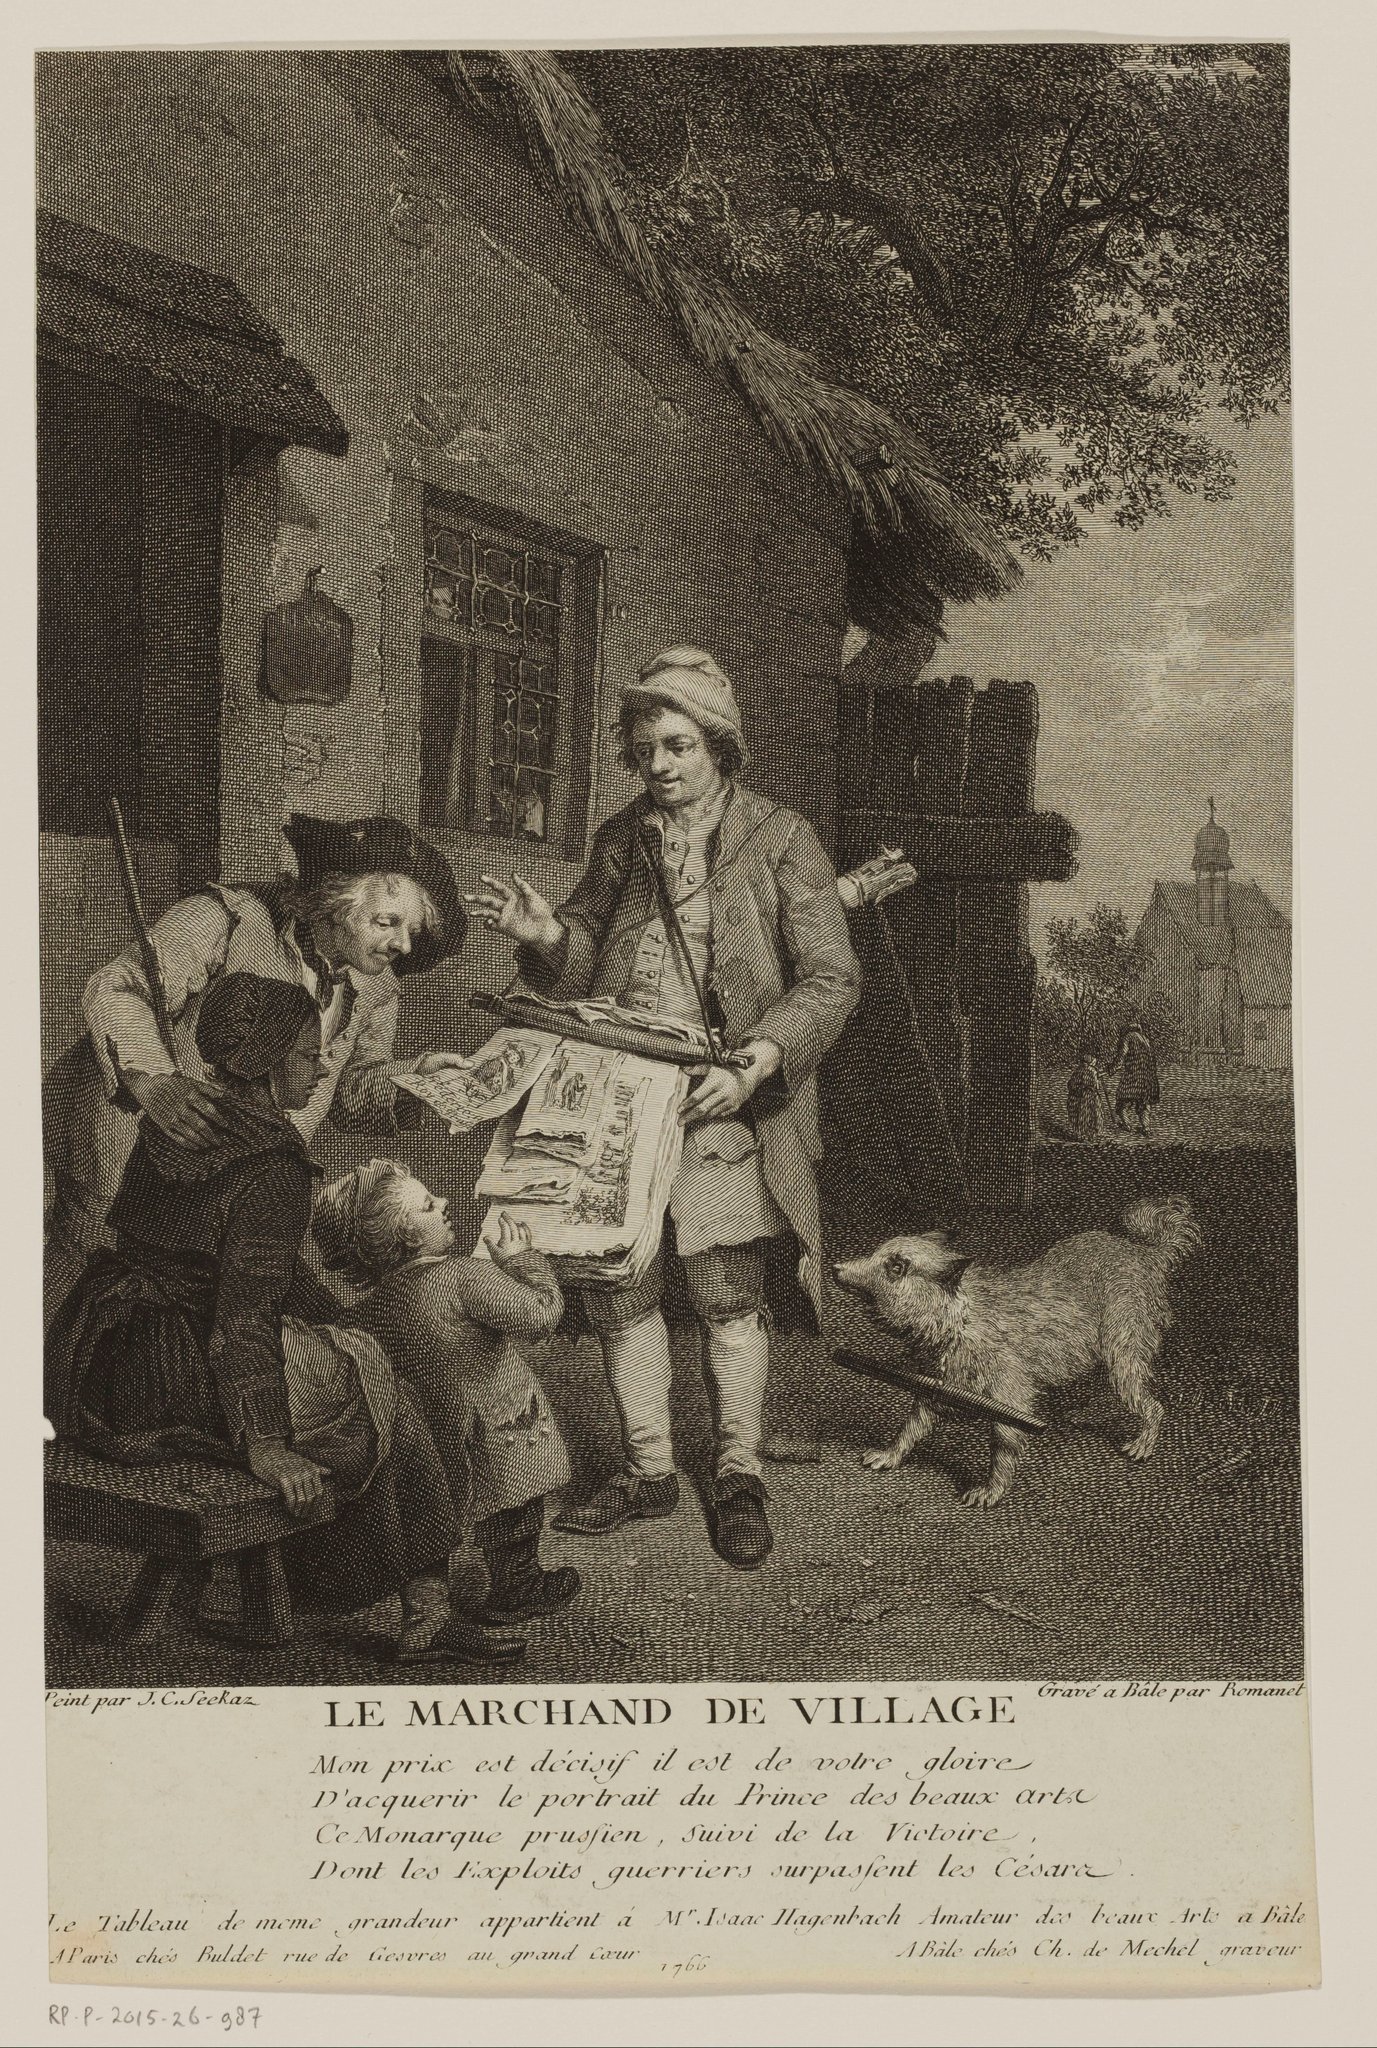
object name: print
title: Le Marchand de Village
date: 1766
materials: paper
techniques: engraving, etching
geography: paris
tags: print, e.g.: engraving, etching, lithograph, book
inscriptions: collector's mark: Lugt 4780, collector's mark: Lugt 4779, collector's mark: Lugt 2228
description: Een rondreizende prentverkoper toont zijn prenten aan een man, een vrouw en een kind. De man bekijkt een portret van Frederik van Pruissen. Naast de prentverkoper staat een hond, in de achtergrond een kerktoren.